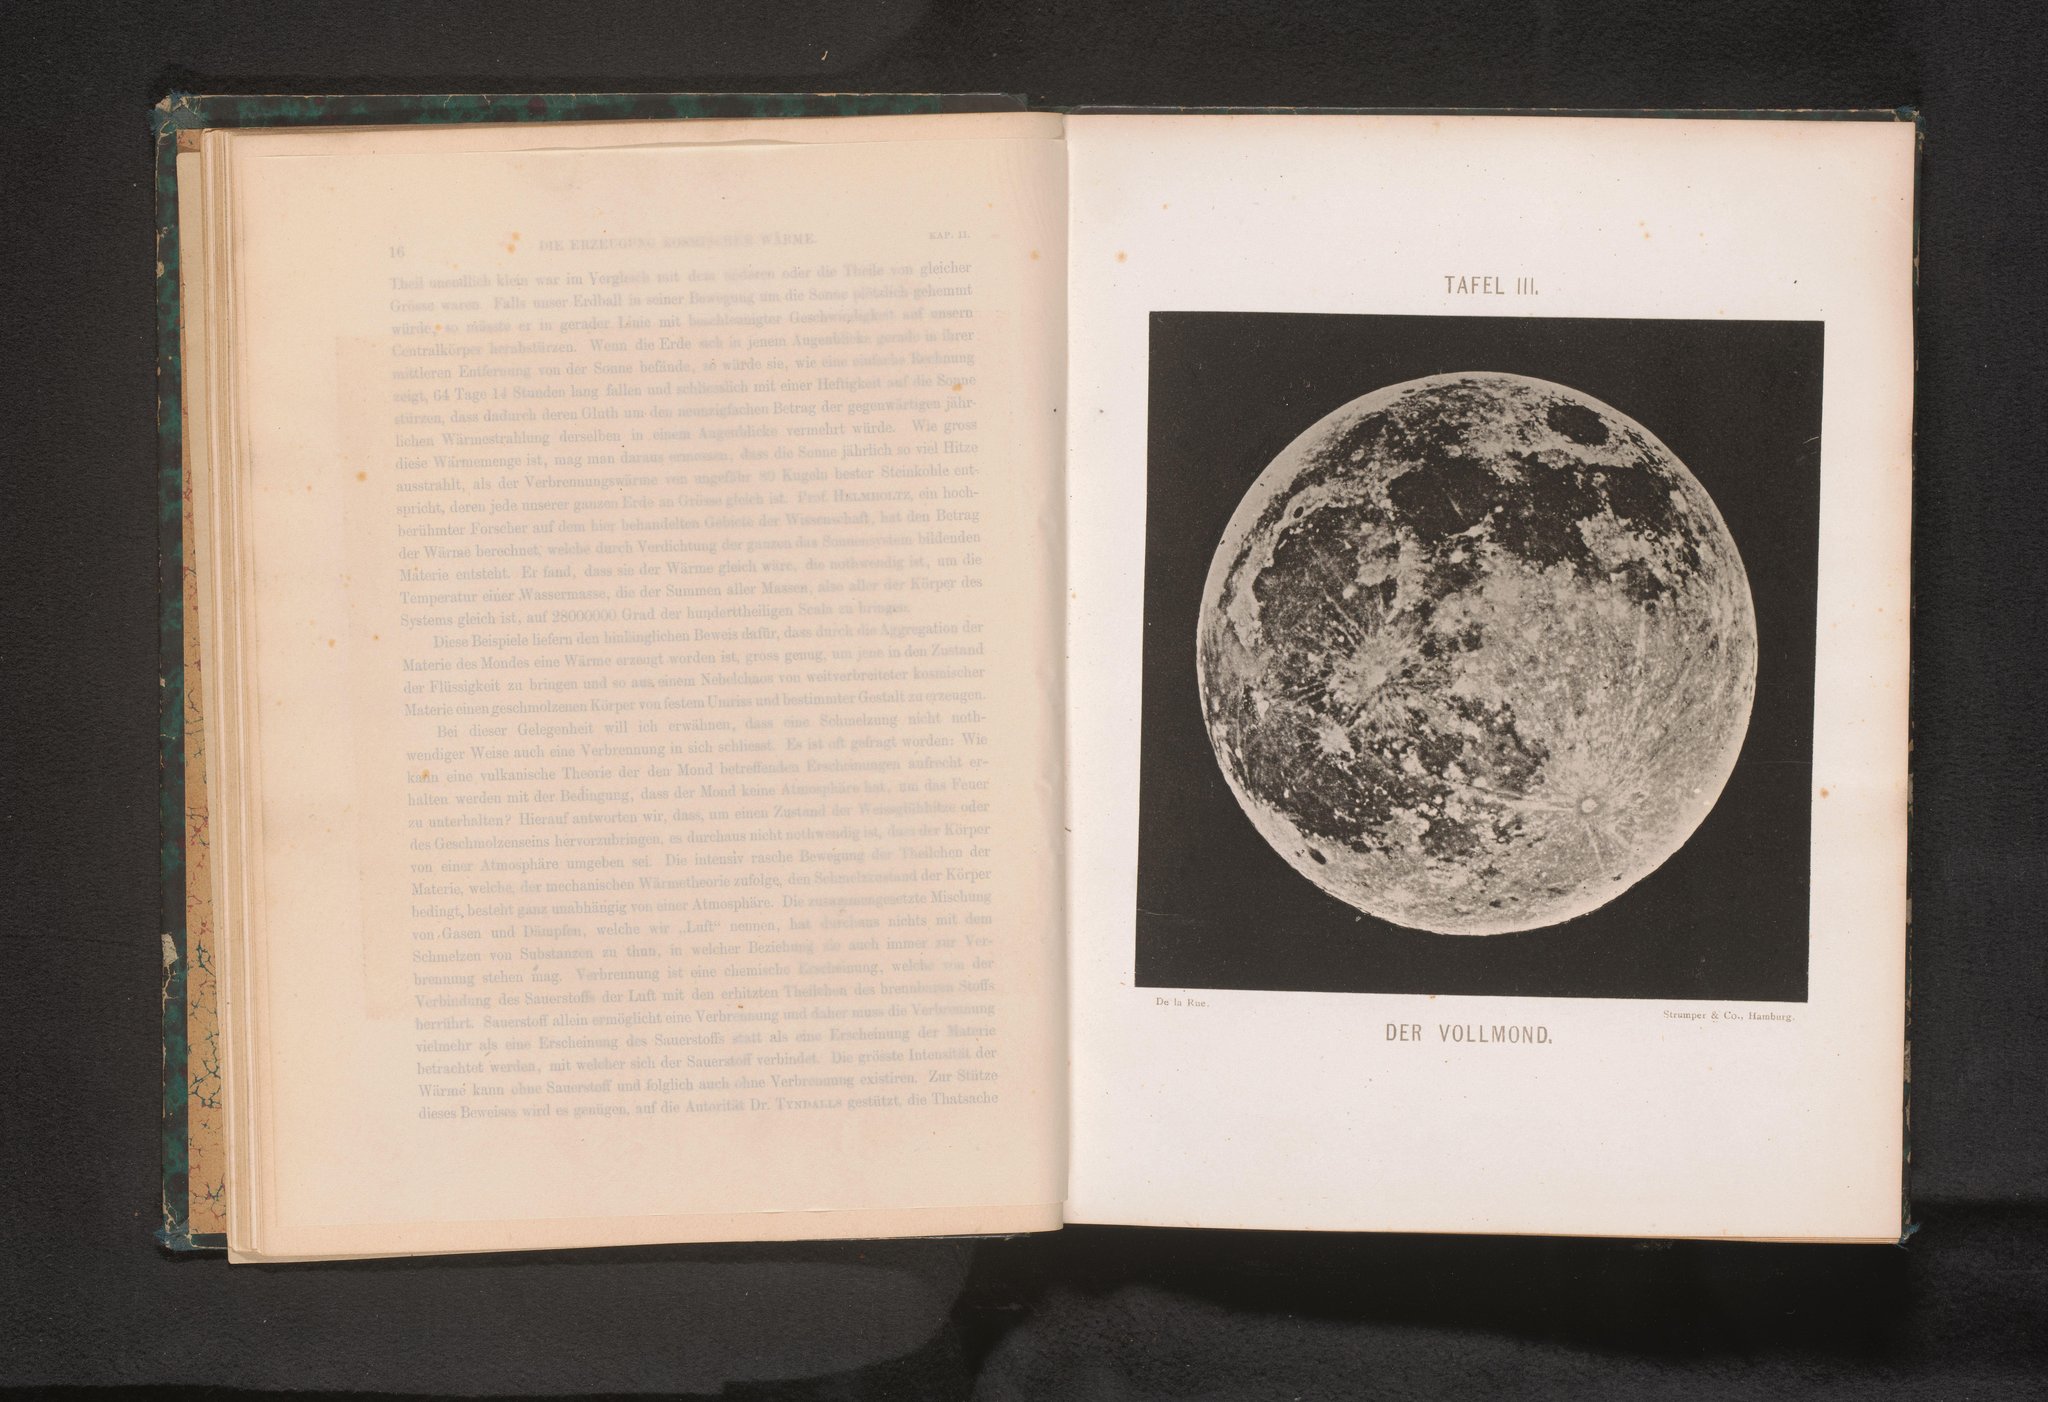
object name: page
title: Volle maan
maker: warren de la rue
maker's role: astronoom, fotograaf, scheikundige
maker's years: 1815-1889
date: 1863-1873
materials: paper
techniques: photograph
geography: hamburg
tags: full moon, moon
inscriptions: number: ‘Tafel III.’